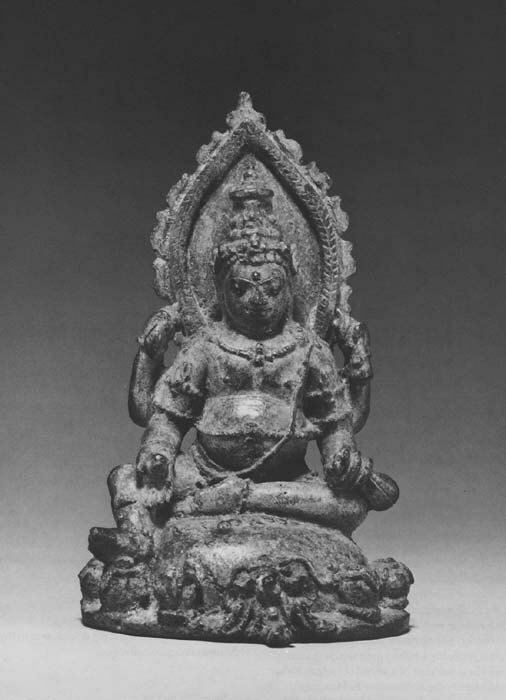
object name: figure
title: Seated Four Armed Jambhala, the Buddhist God of Wealth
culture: indonesian, javanese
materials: bronze, silver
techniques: inlay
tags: buddhism,deities